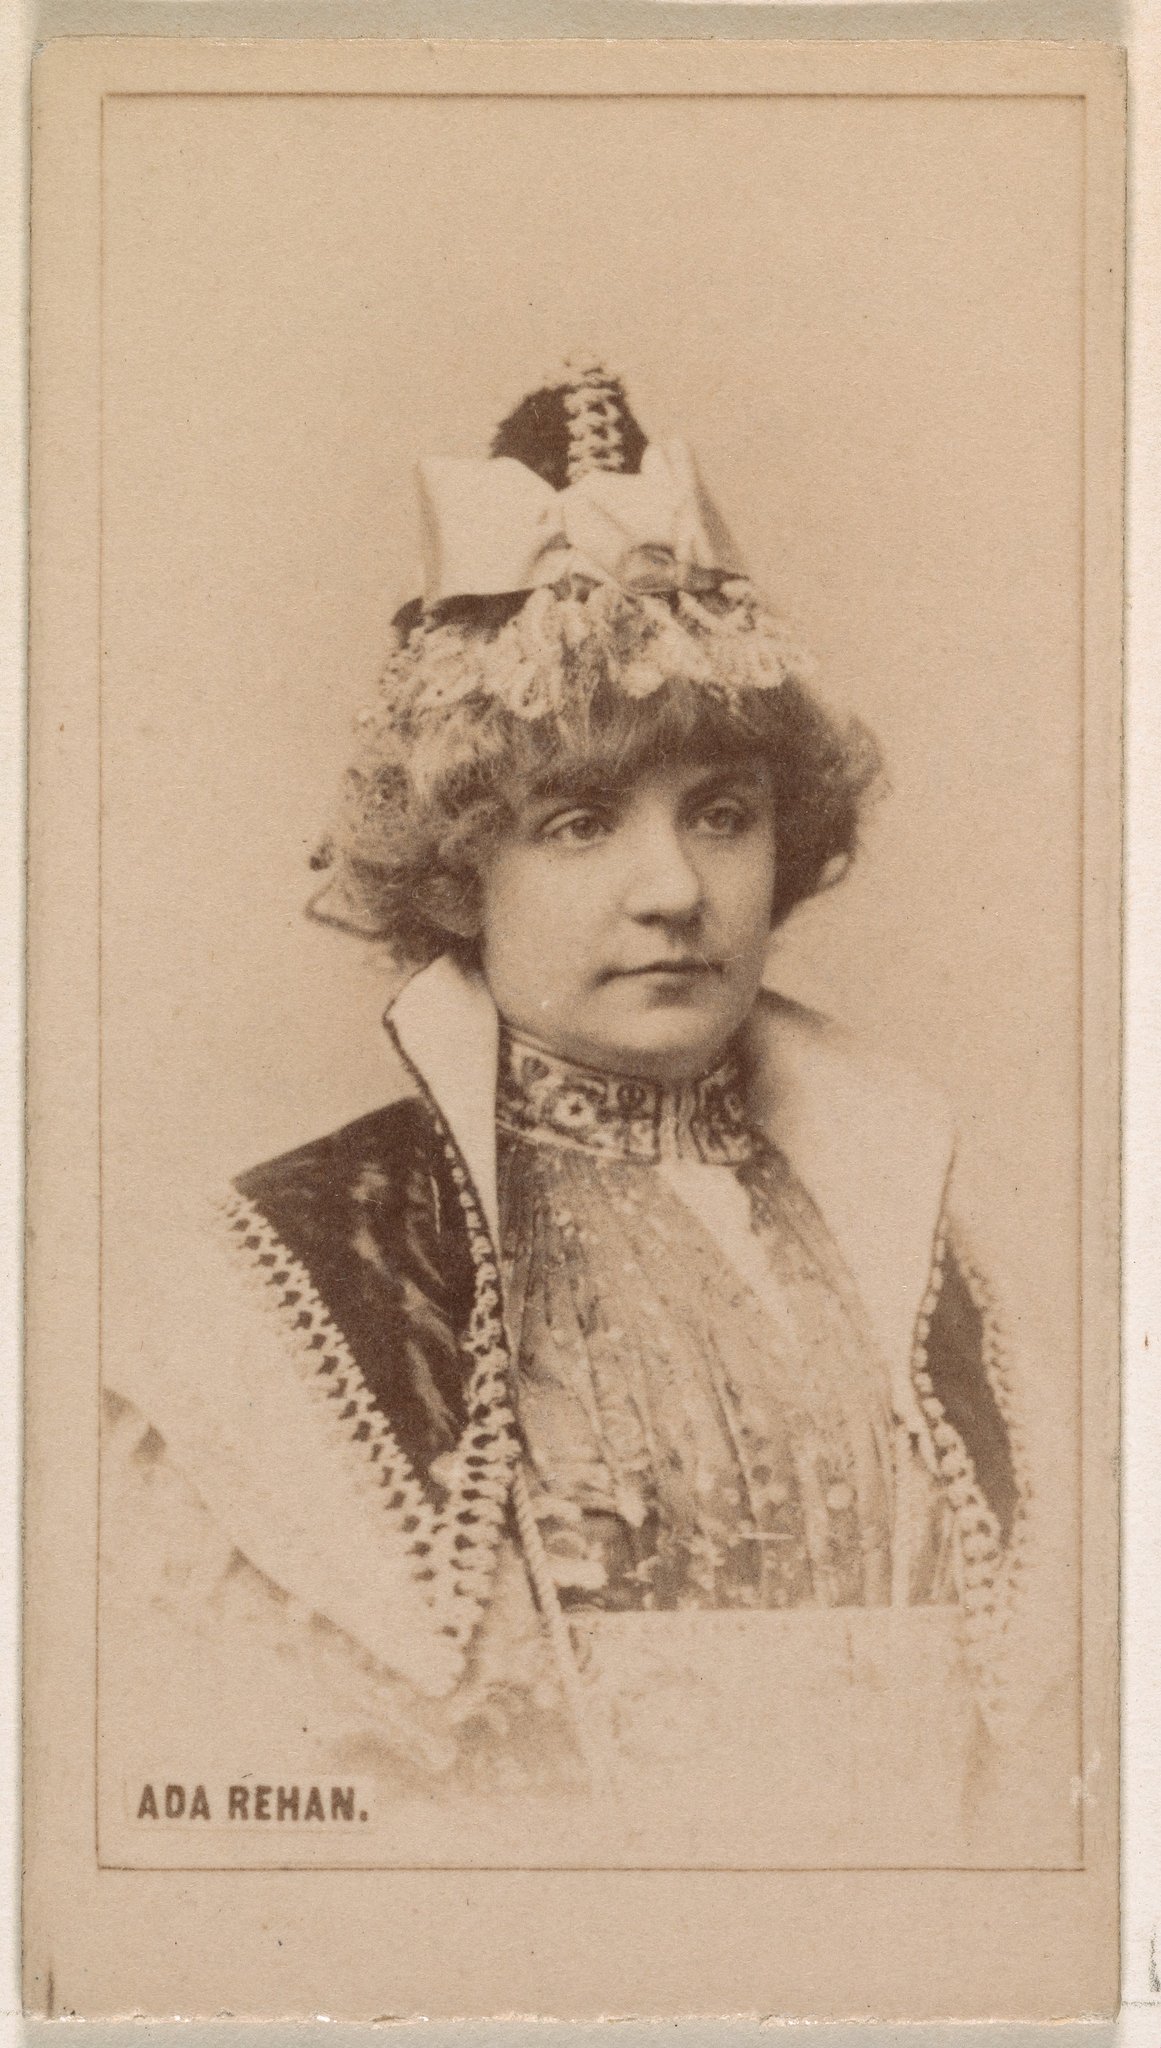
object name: photograph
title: Ada Rehan, from the Actresses series (N245) issued by Kinney Brothers to promote Sweet Caporal Cigarettes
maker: kinney brothers tobacco company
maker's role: publisher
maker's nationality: american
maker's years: 1869-2011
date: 1890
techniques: albumen silver print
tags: portraits,women,actresses